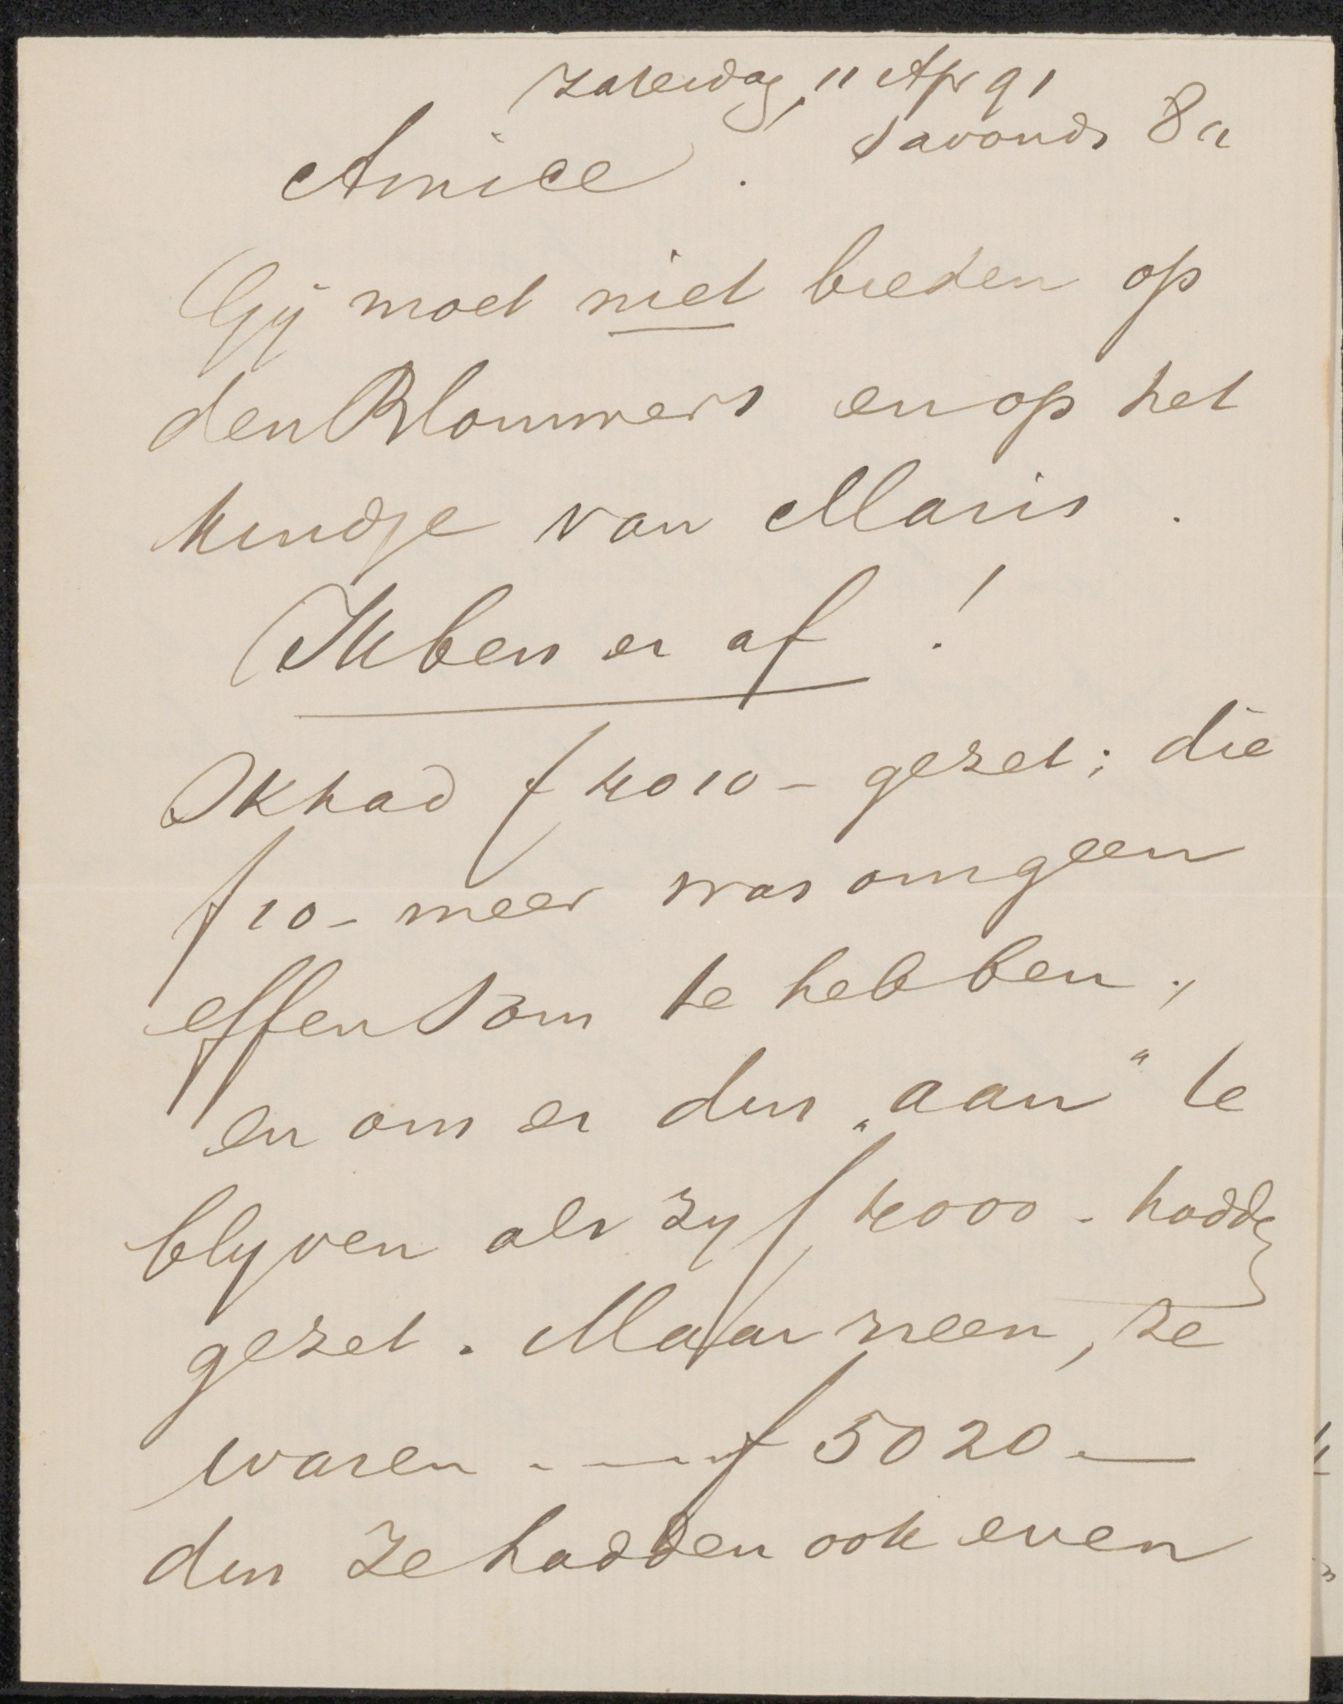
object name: letter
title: Brief aan Jan Veth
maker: martinus cornelis lebret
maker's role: verzamelaar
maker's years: 1833-1894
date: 1891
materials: ink, paper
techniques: pen, writing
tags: bernardus johannes blommers, dordrecht, amsterdam, painter, draughtsman, designer, jan veth, money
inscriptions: collector's mark: ‘RPK’